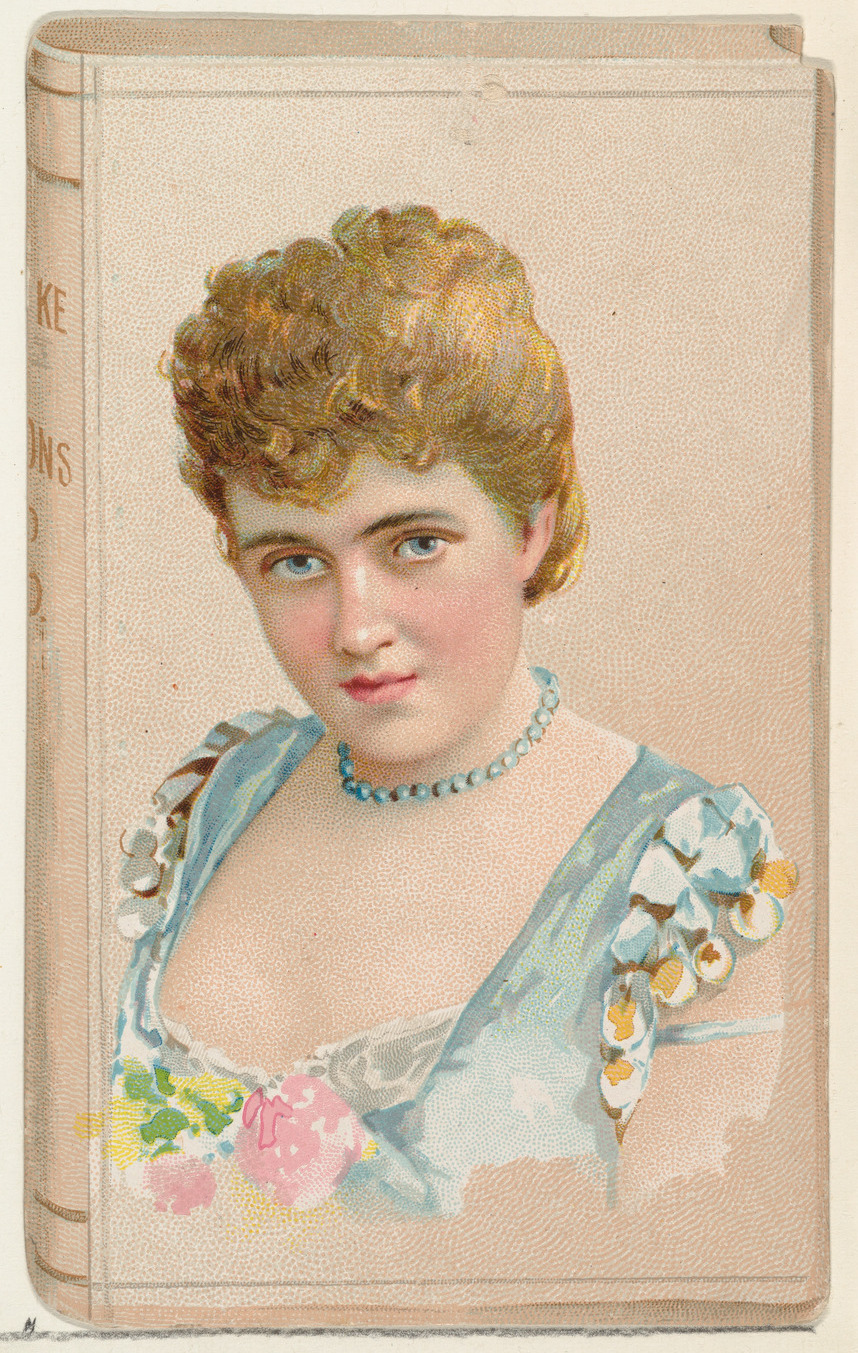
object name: print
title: Book, from the Novelties series (N122) issued by Gail & Ax Tobacco to promote Navy Long Cut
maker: gail & ax tobacco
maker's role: publisher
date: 1889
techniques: color lithograph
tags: books,women